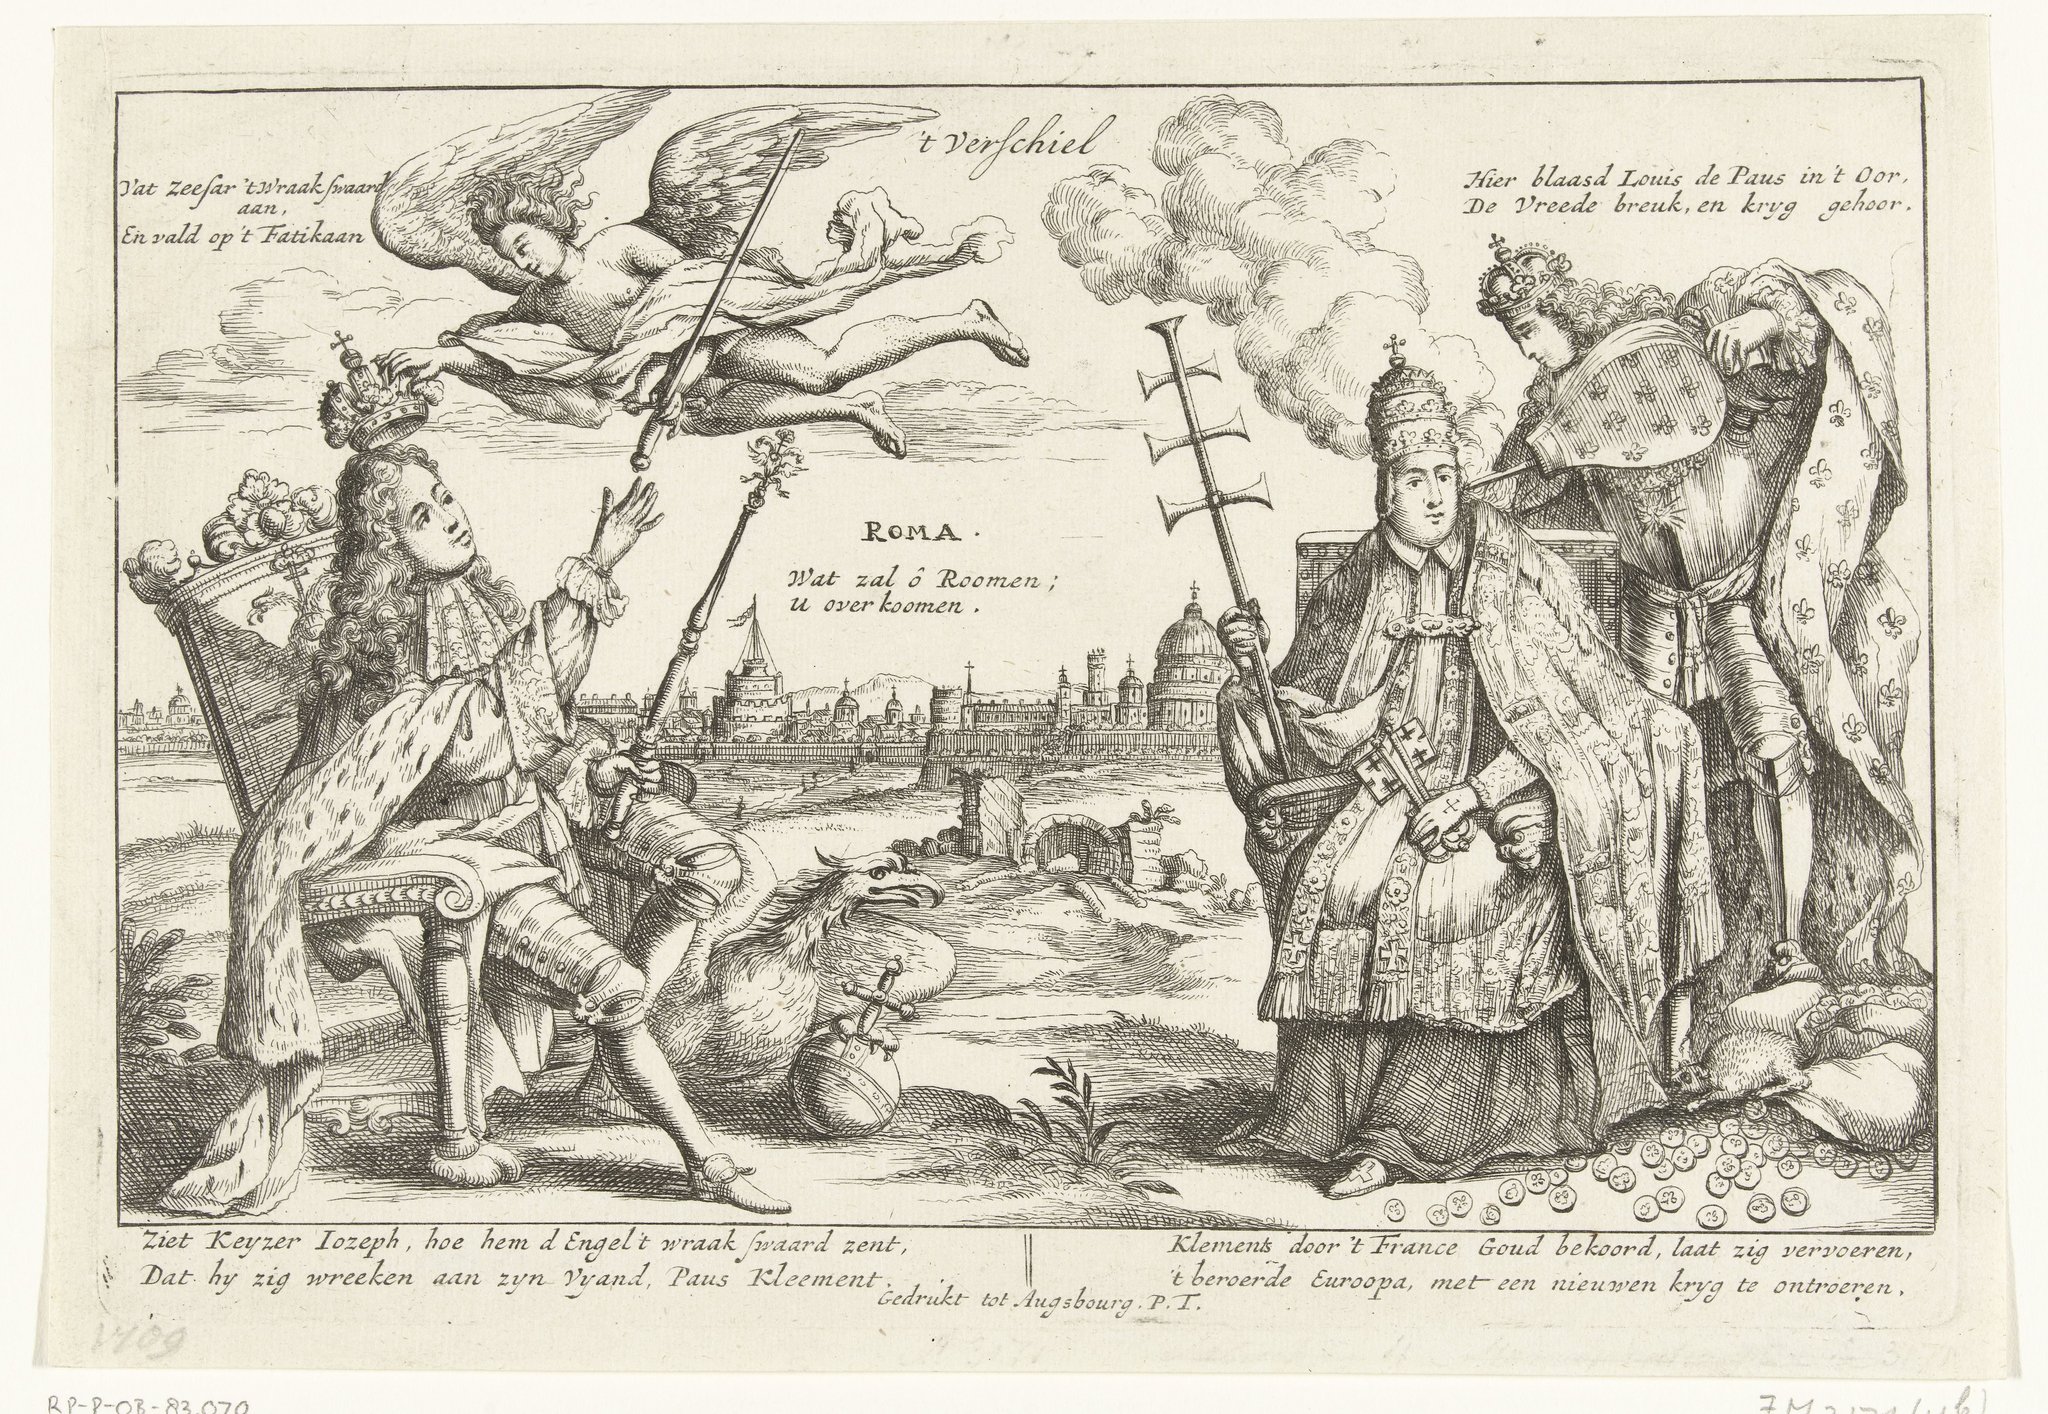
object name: cartoon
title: Palmhof der Bondgenooten / 't Lusthof van Momus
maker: carel allard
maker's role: print maker, publisher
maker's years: 1648-1709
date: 1708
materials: paper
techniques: engraving, etching, letterpress printing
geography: northern netherlands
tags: lodewijk xiv (koning van frankrijk), jozef i (duits keizer), rome, clergyman, clemens xi, political caricatures and satires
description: Spotprent waarin keizer Jozef I van een engel het zwaard van de wraak krijgt aangereikt. Tegenover hem blaast koning Lodewijk XIV van Frankrijk met een blaasbalg in het oor van paus Clemens XI. Op de achtergrond Rome. Verzen in de plaat in het Nederlands. Onderdeel van een reeks getiteld Palmhof der Bondgenooten met 9 spotprenten op de Fransen en bondgenoten uit het jaar 1708.